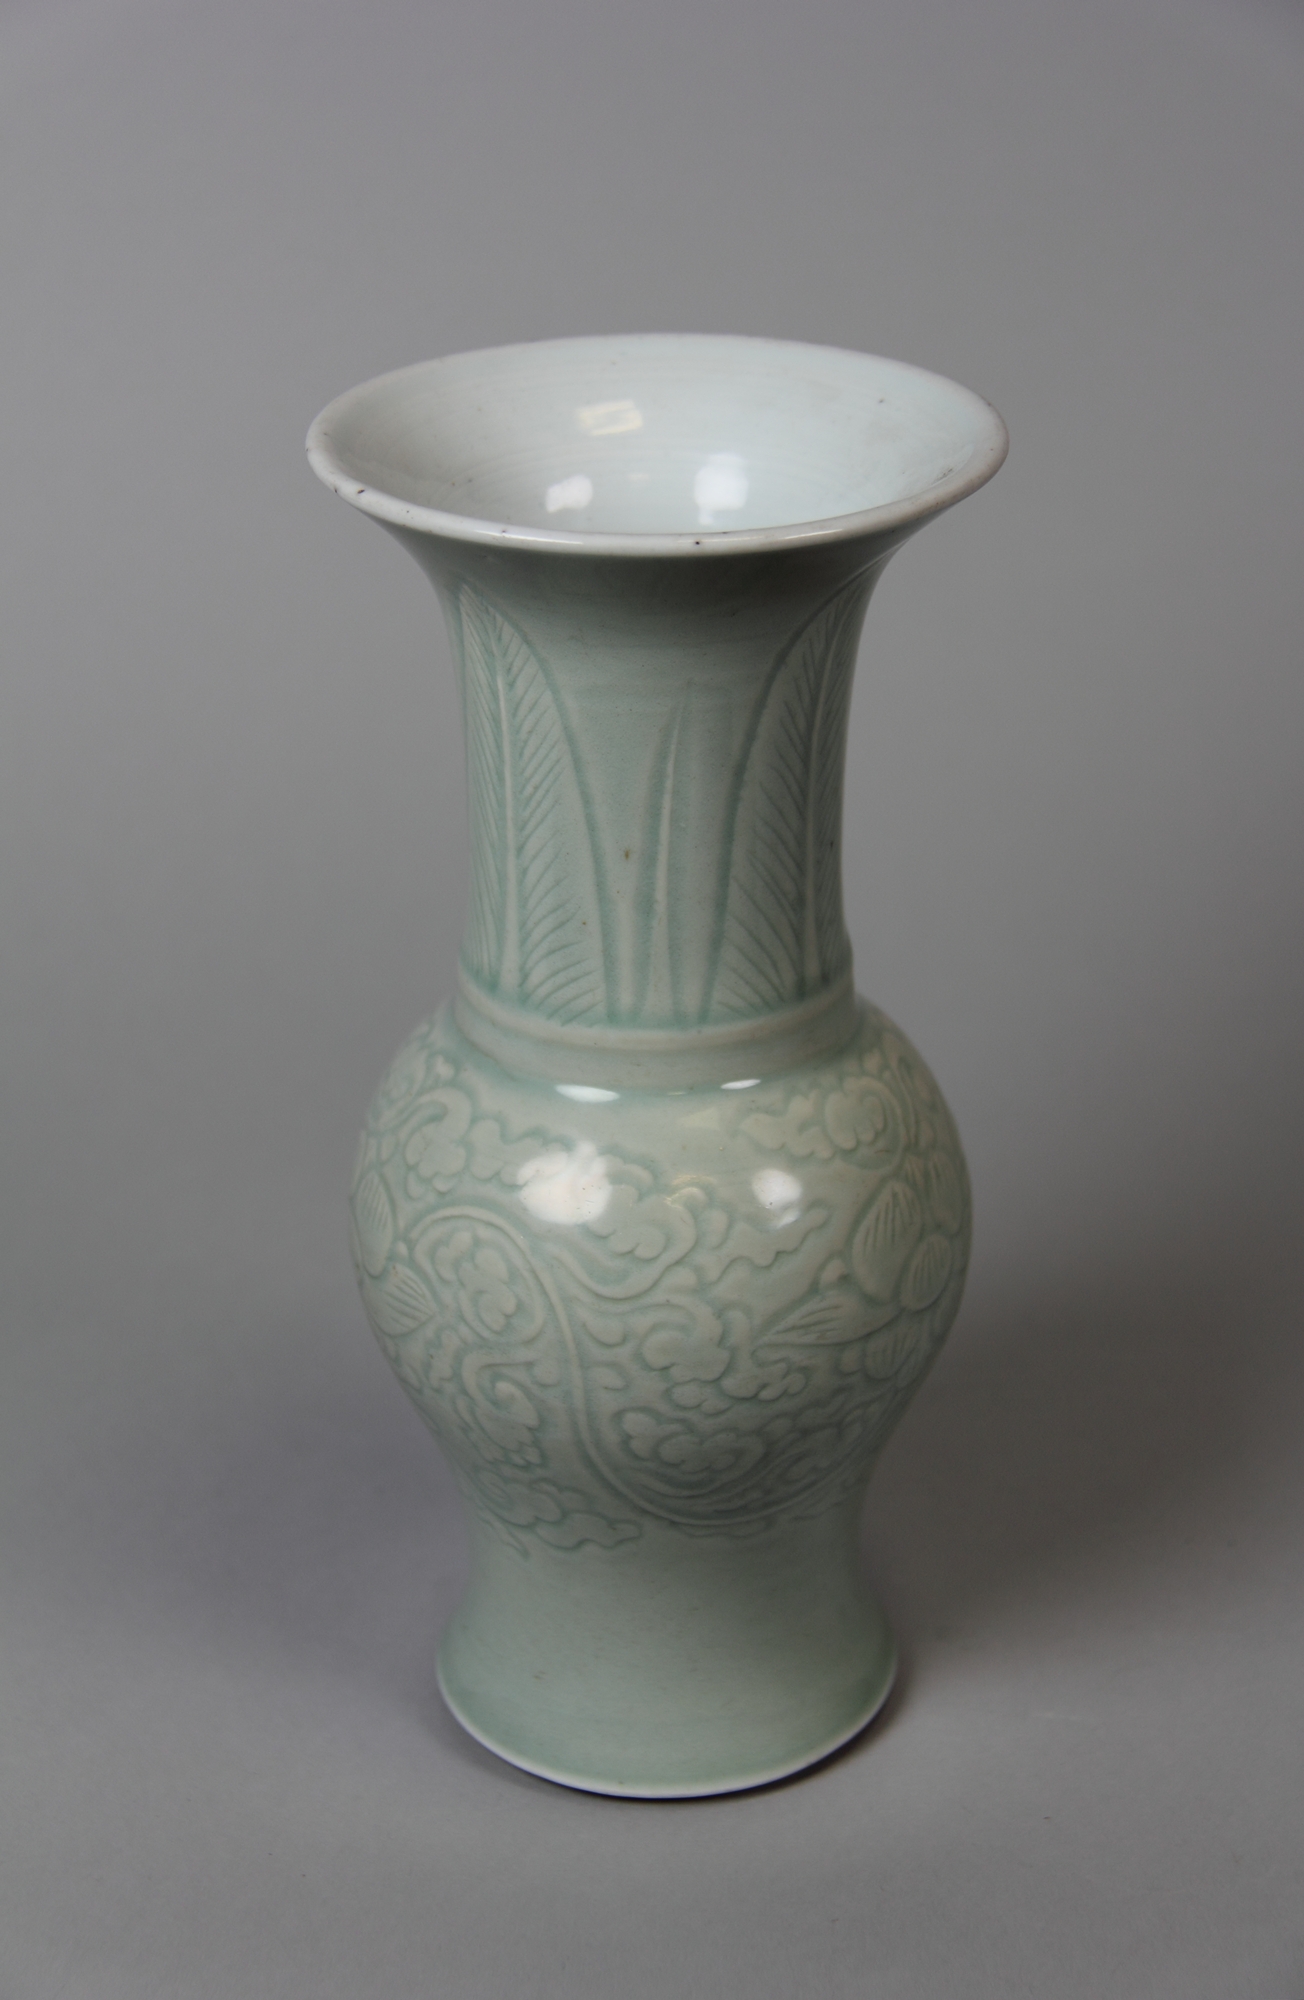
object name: vase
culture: chinese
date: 1622-1722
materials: porcelain